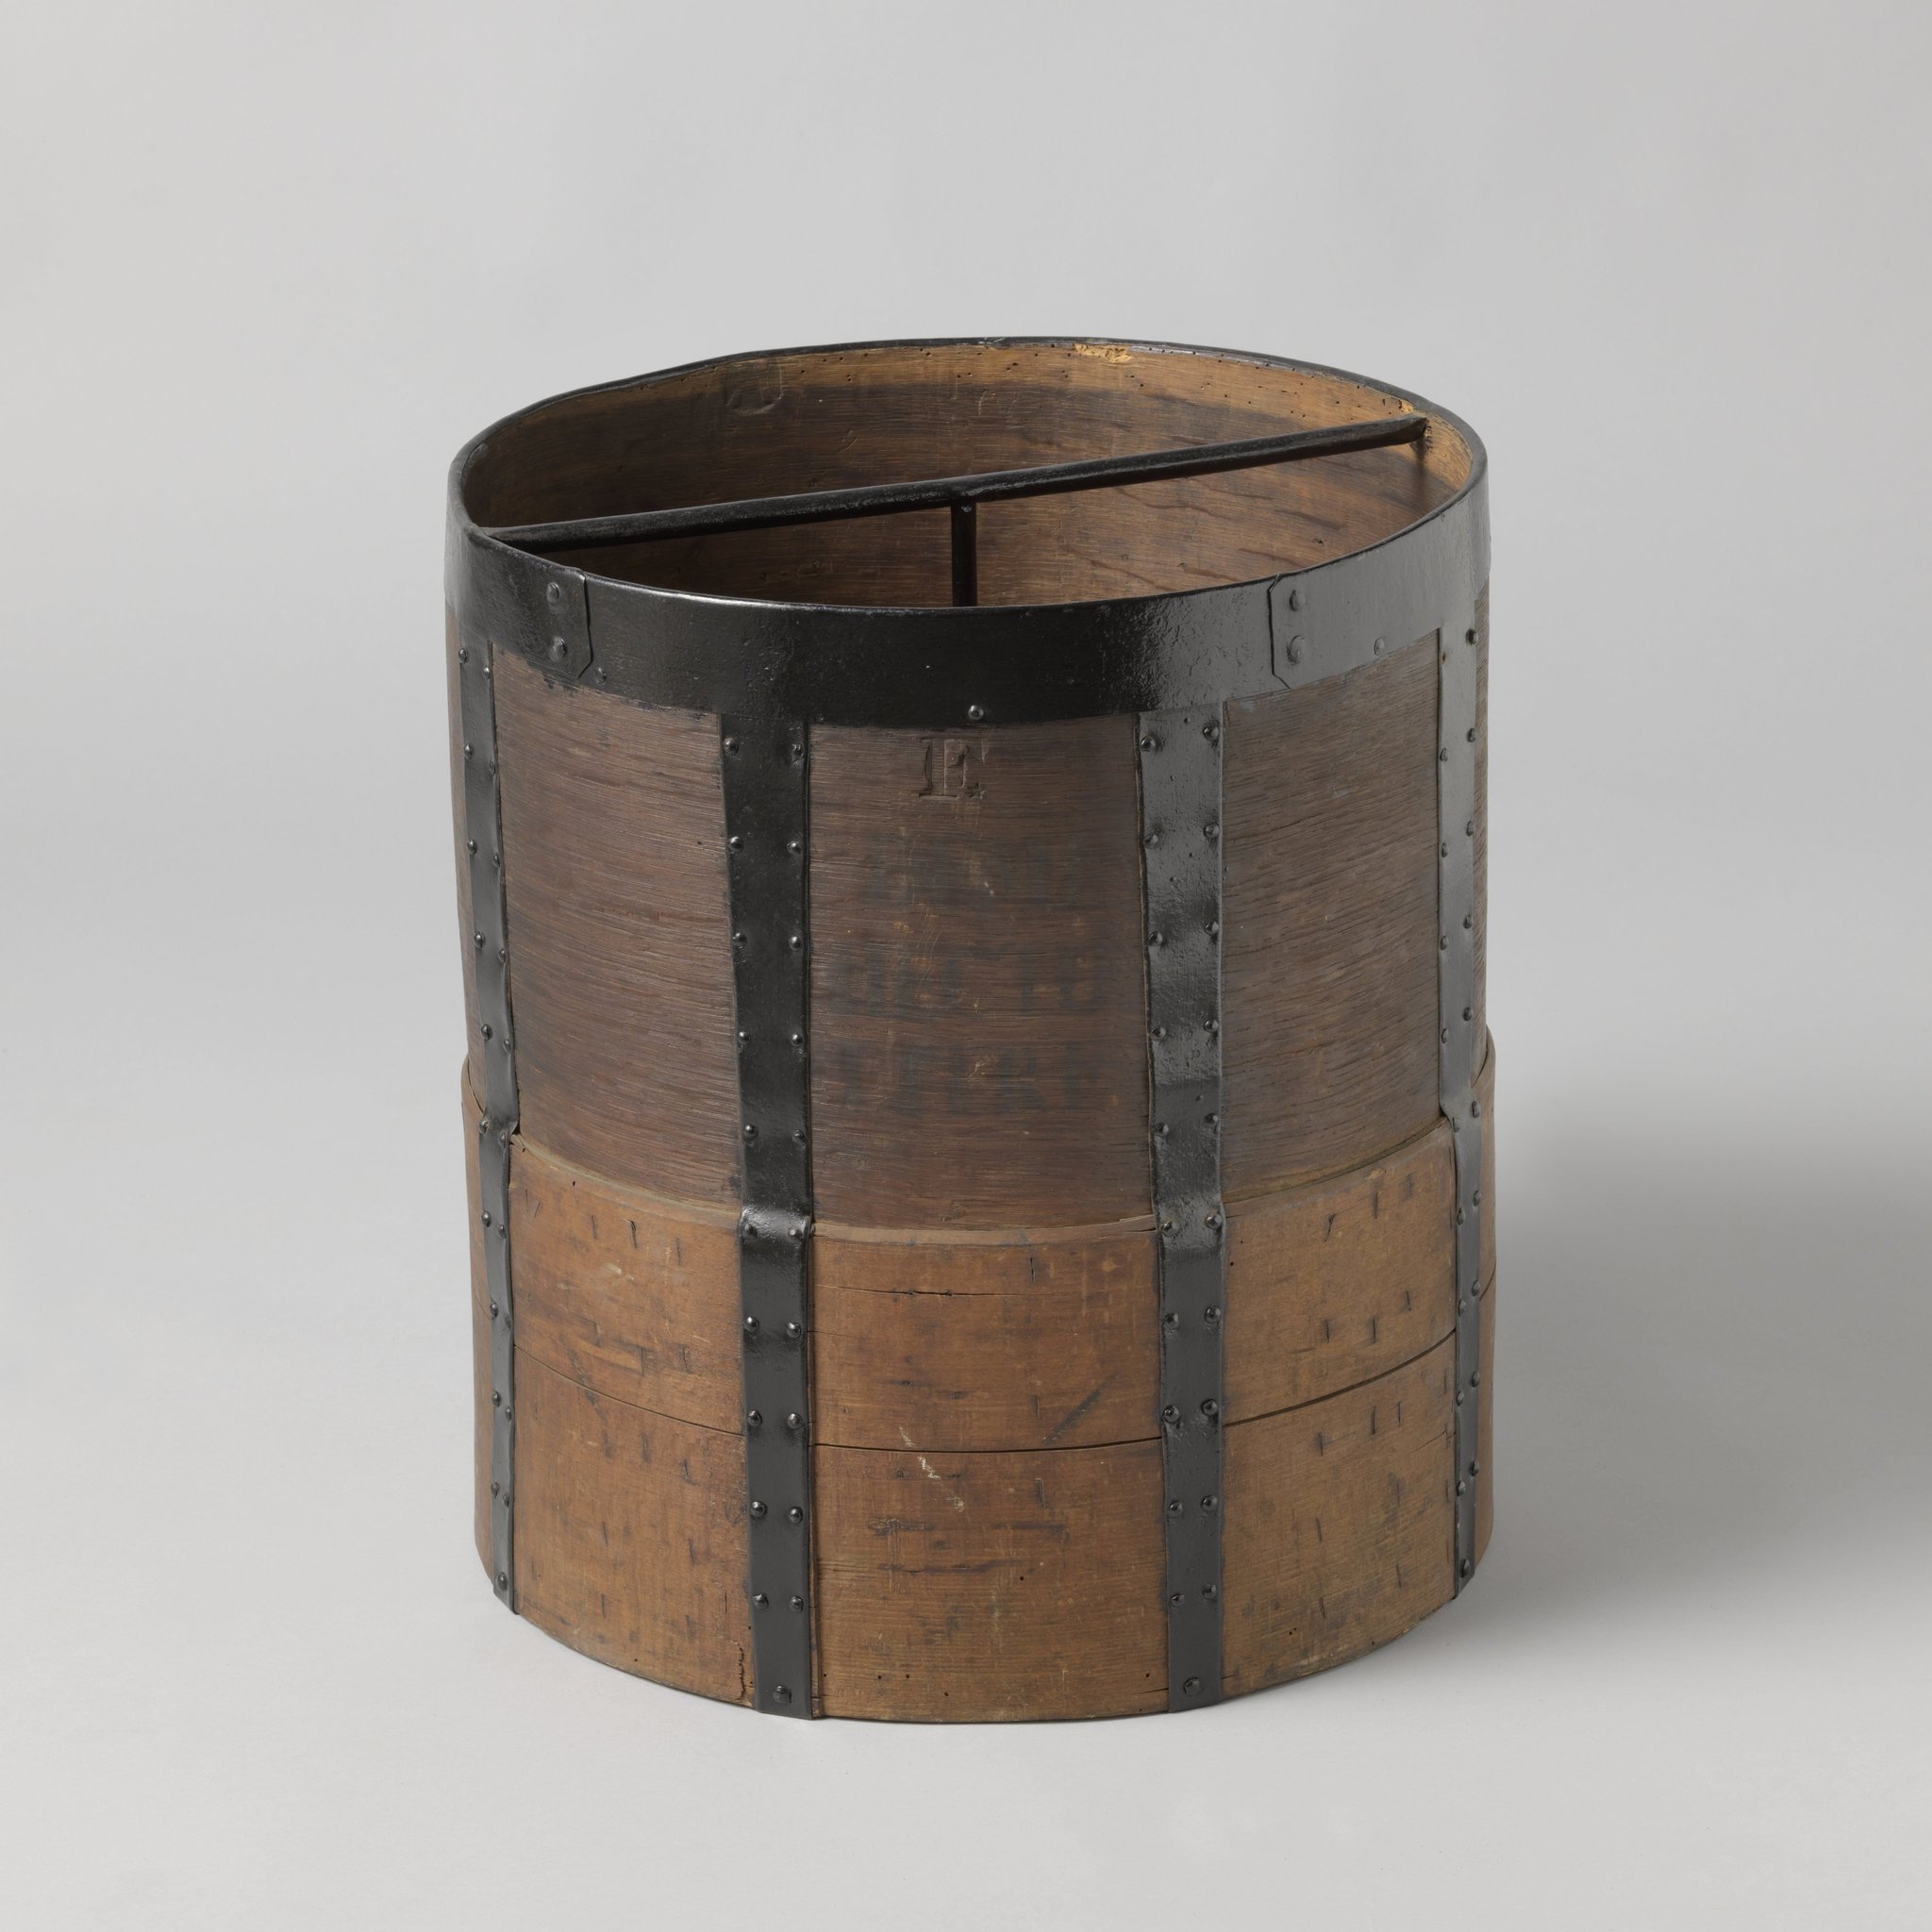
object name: inhoudsmaat droge waren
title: Inhoudsmaat van 1/2 hectoliter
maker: Anonymous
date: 1825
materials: wood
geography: netherlands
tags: netherlands